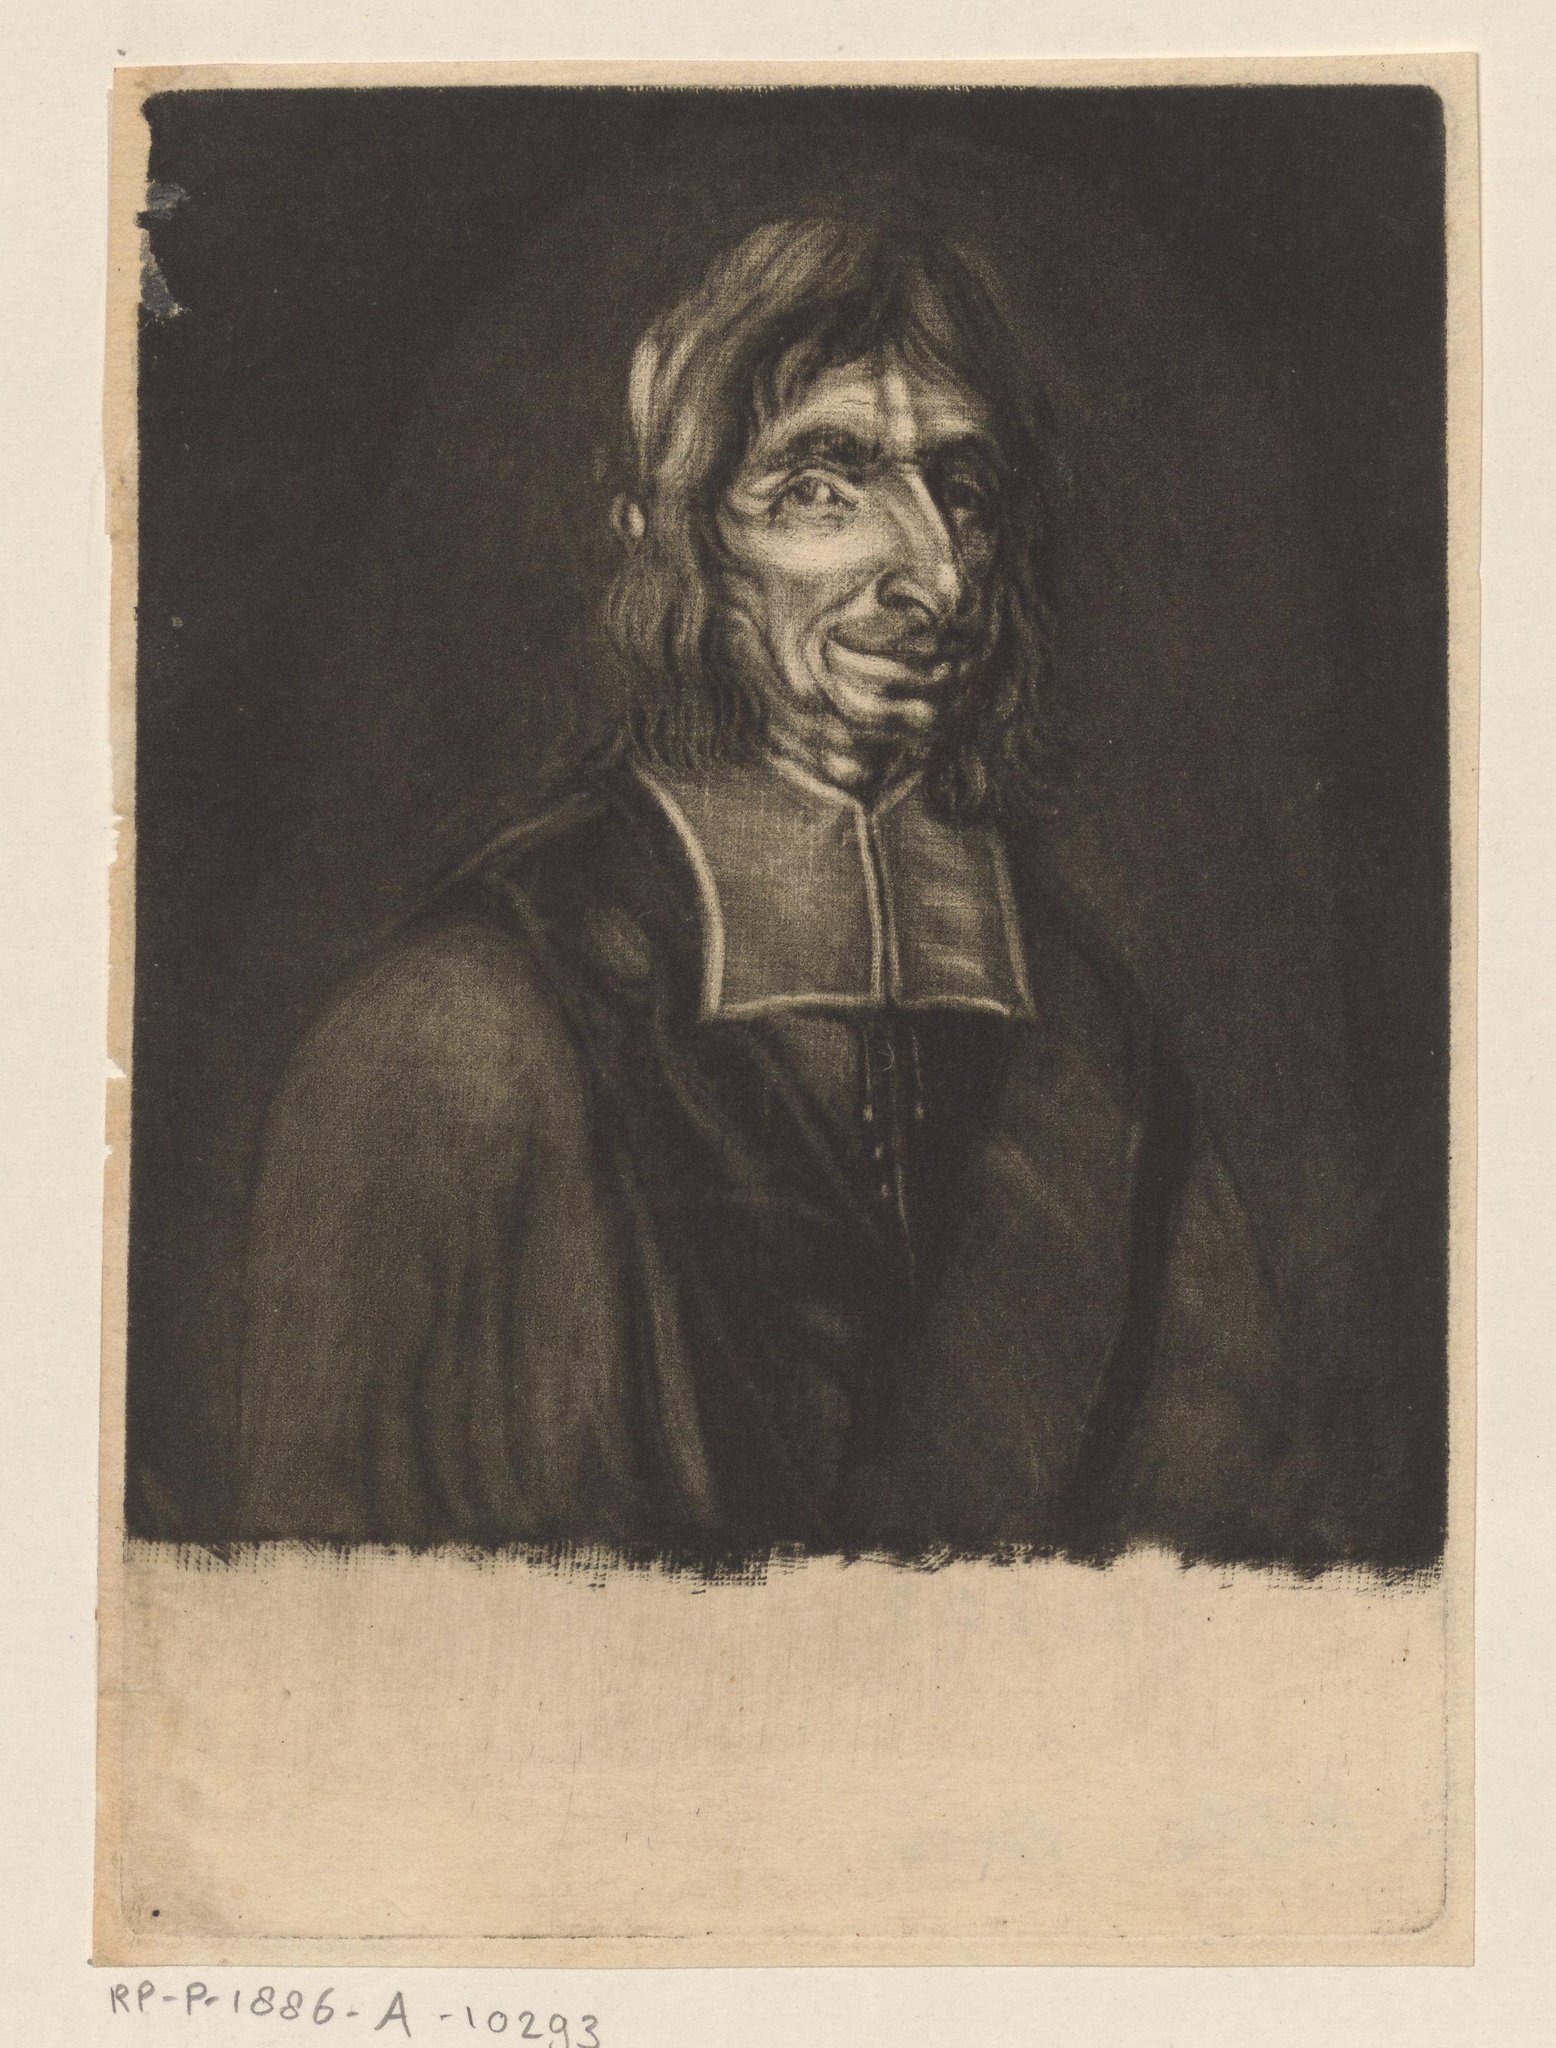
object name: print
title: Portret van Balthasar Bekker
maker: Anonymous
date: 1675-1725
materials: paper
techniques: mezzotint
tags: balthasar bekker, historical persons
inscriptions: collector's mark: Lugt 2228